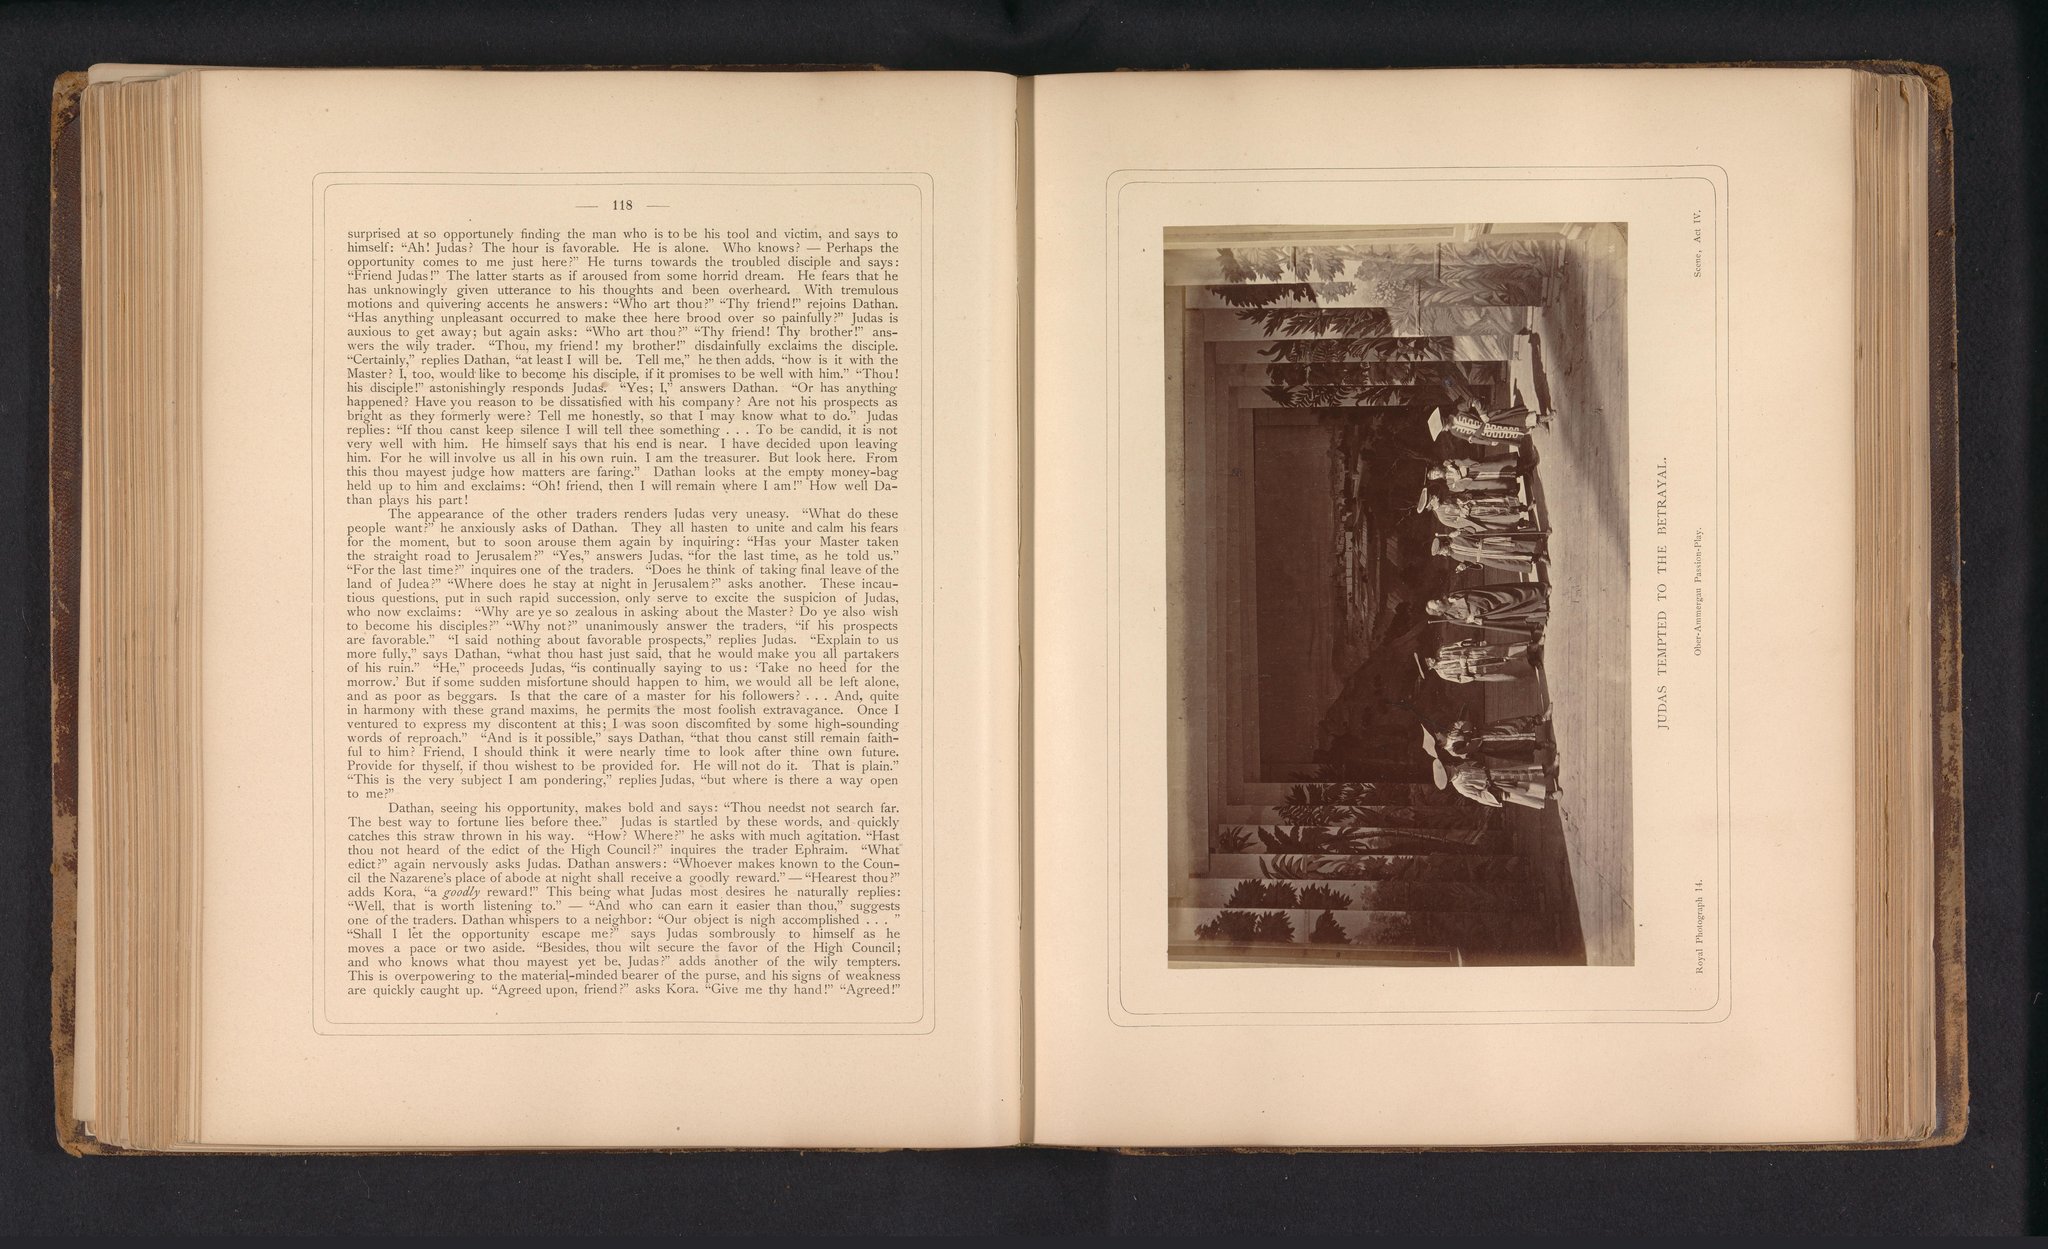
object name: page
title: Judas tempted to the betrayal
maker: joseph albert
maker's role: printer, publisher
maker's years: 1825-1886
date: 1868-1873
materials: photographic support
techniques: albumen print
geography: oberammergau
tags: group of actors, troupe; actors on the stage, judas goes out to the chief priests, betrays christ and receives the reward (matthew 26:14-16; mark 14:10-11; luke 22:4-6)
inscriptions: number: ‘Royal Photograph 14.’